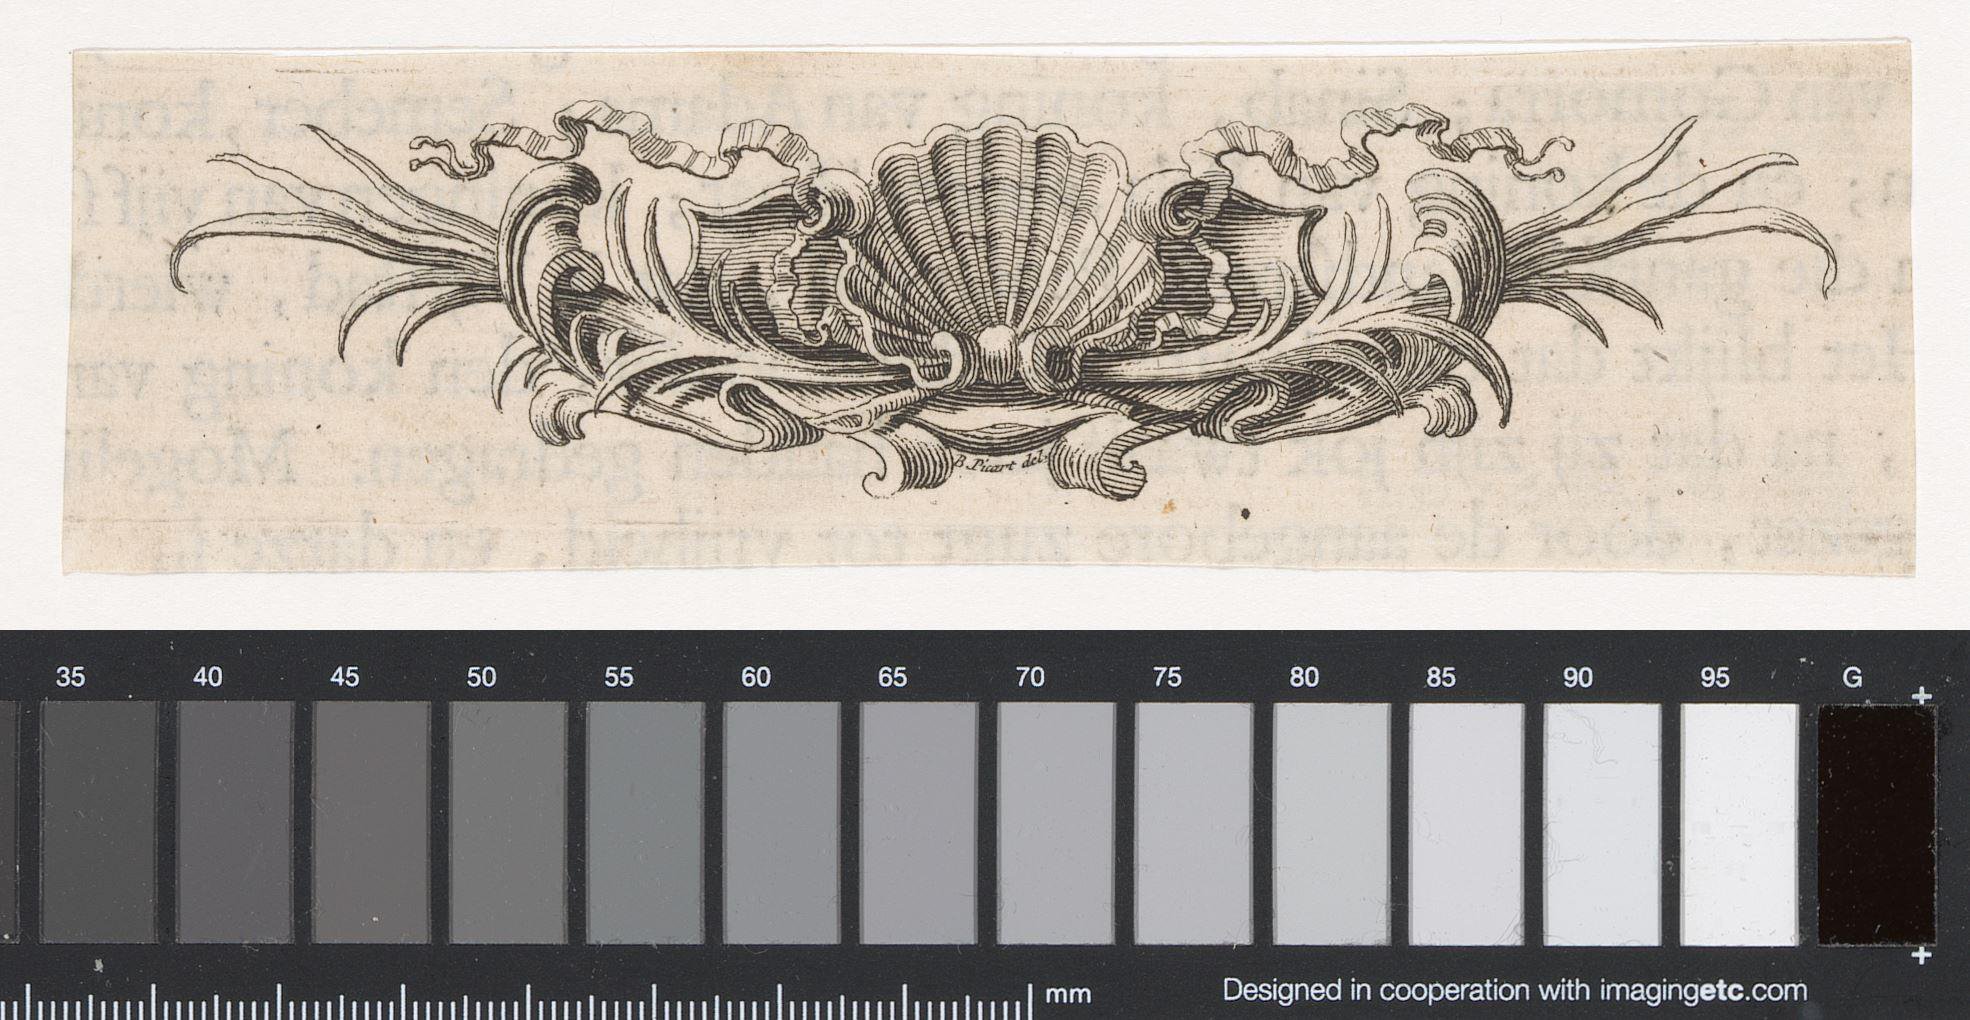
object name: book illustration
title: Ornament met schelp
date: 1683-1733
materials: paper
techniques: etching, letterpress printing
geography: netherlands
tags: ornaments ~ art, scallop, shell ~ ornament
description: Een ornament met een schelp, bladmotieven en linten.